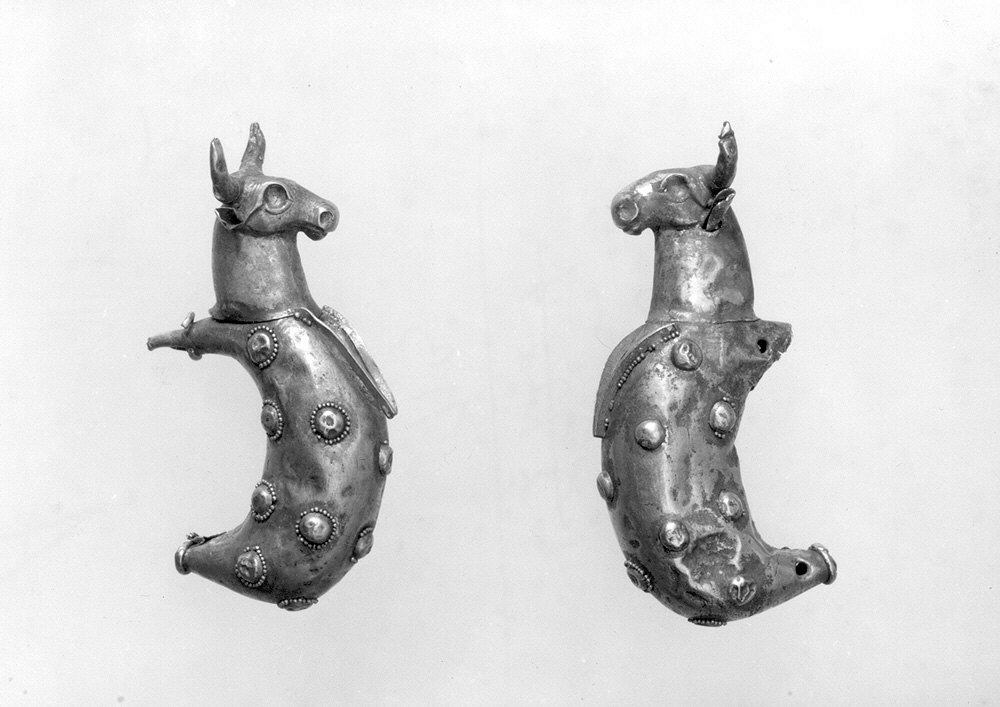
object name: earring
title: Crescent-shaped earrings with bulls' heads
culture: iranian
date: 1000-668 BCE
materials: gold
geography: northwestern iran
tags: bulls